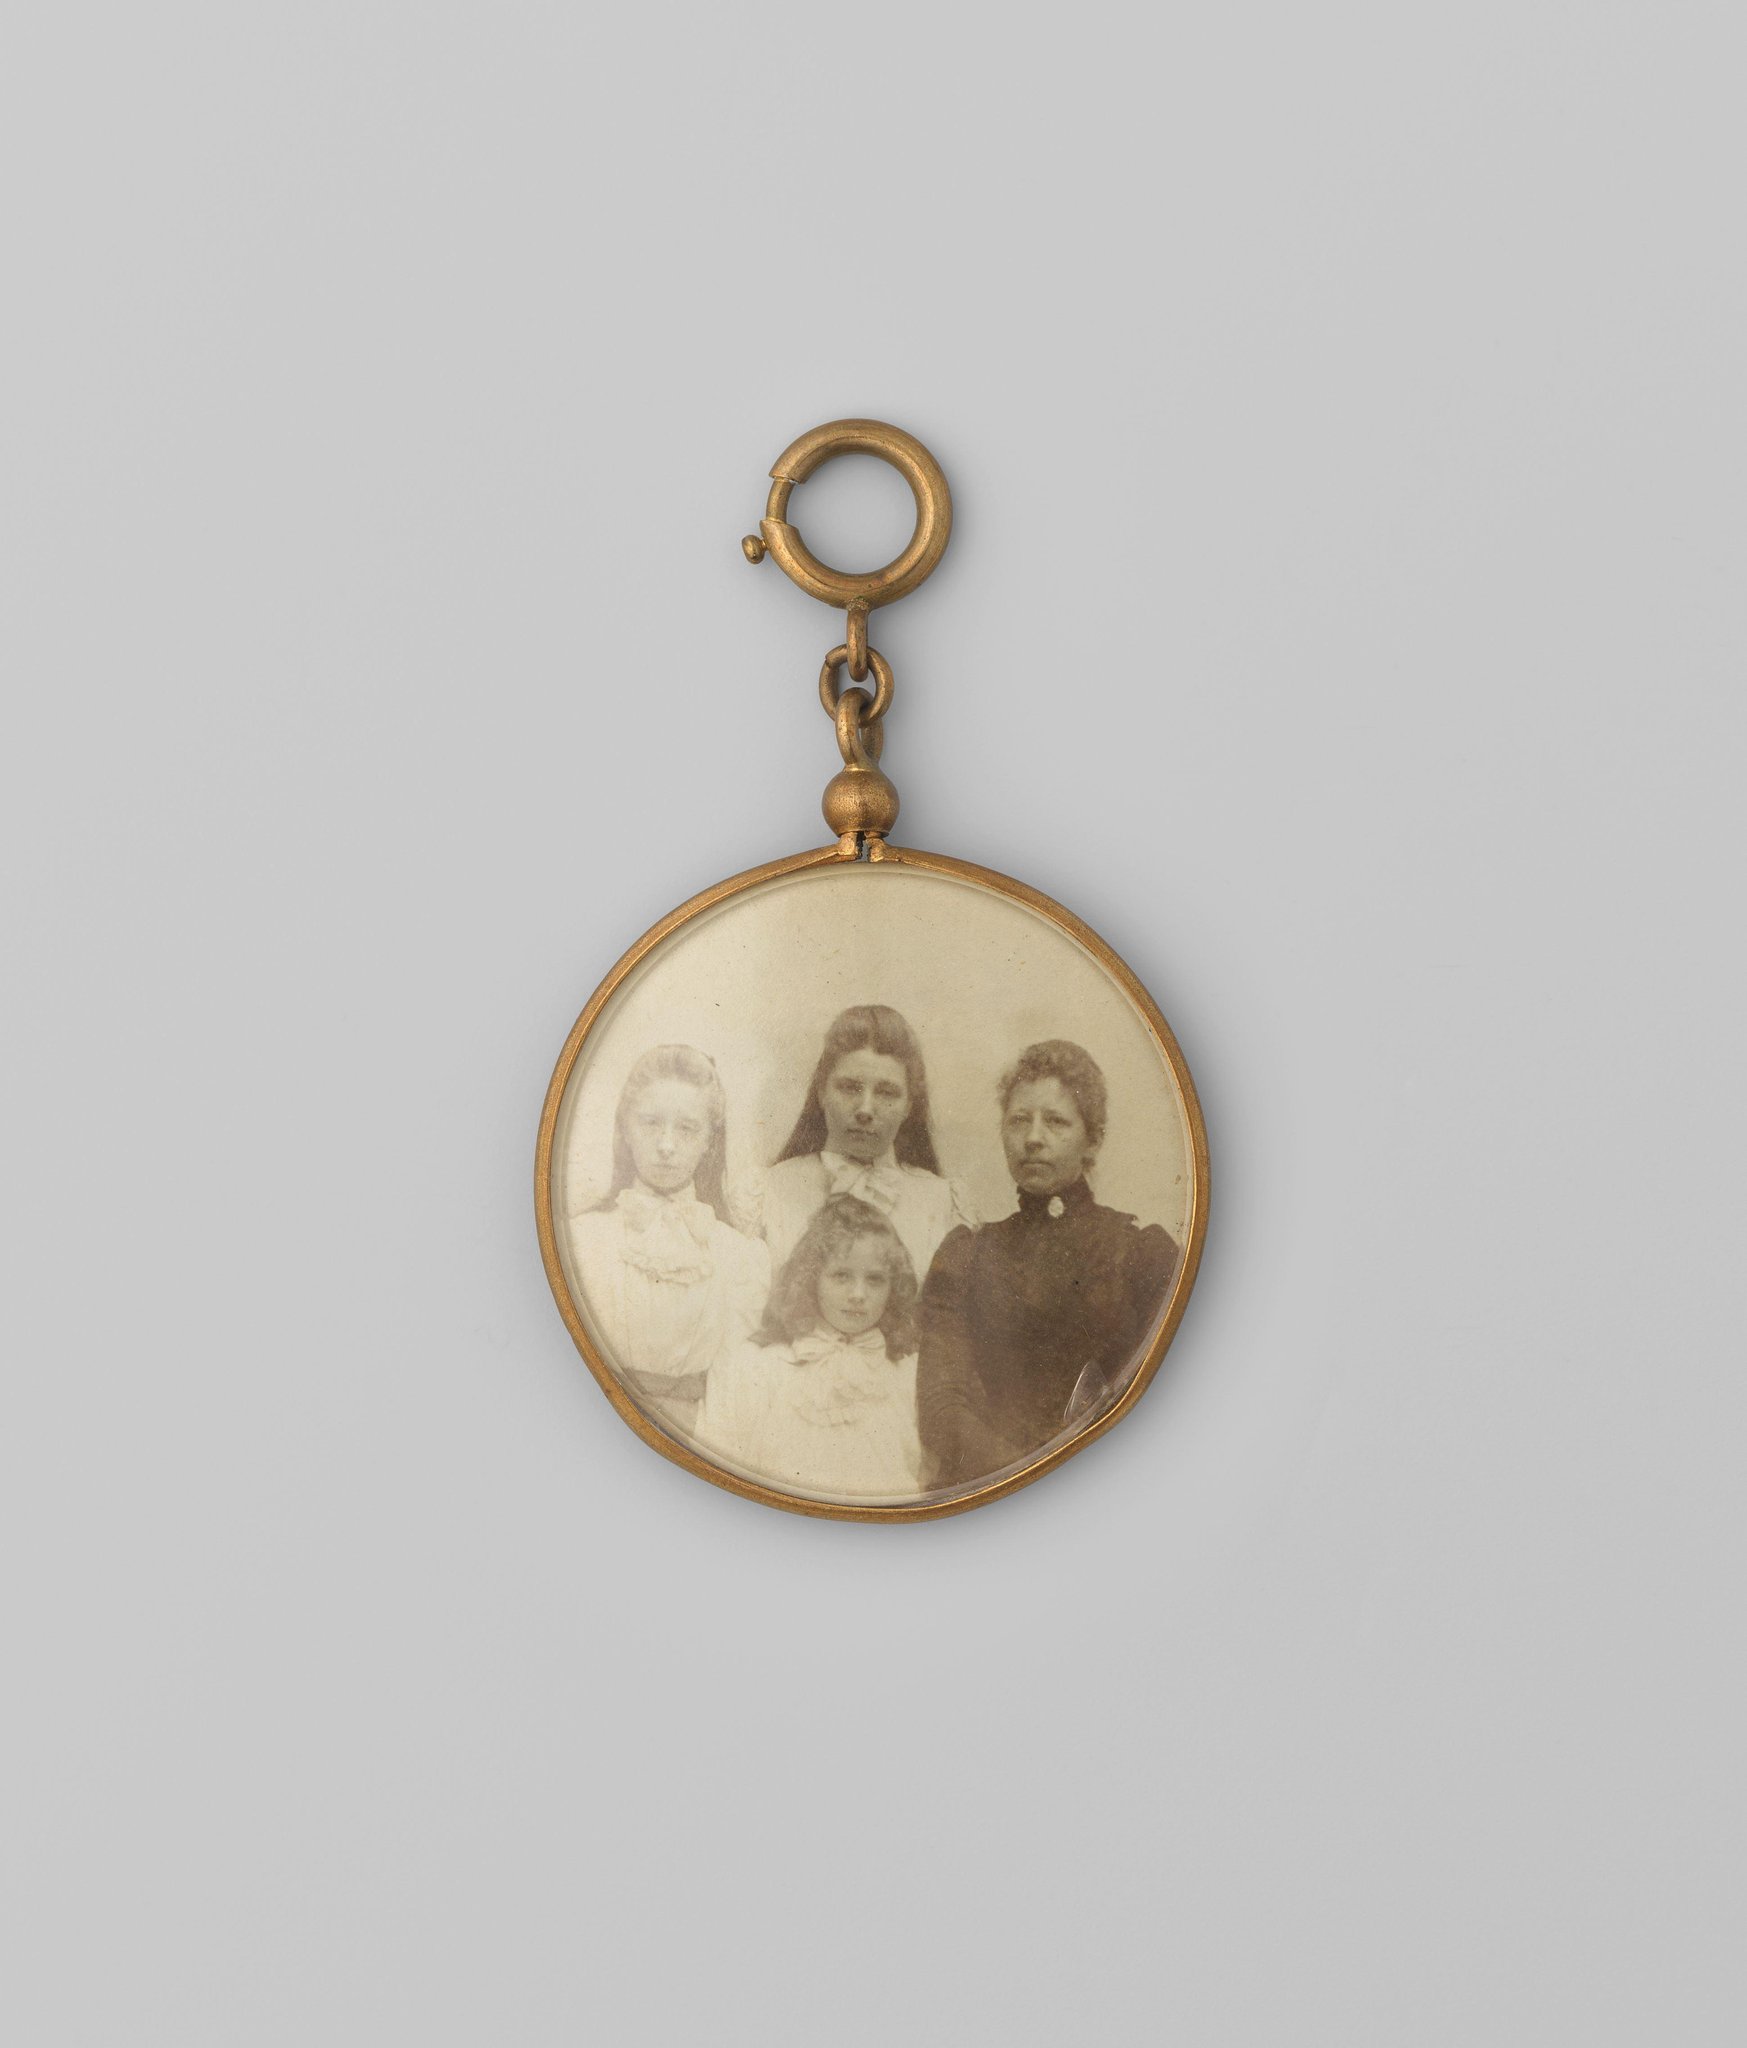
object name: photograph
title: Groepsportretfoto van vier onbekende vrouwen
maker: Anonymous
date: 1880-1910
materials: paper, copper, glass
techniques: gelatin silver print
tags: anonymous historical persons portrayed in a group, in a group-portrait - bb - woman